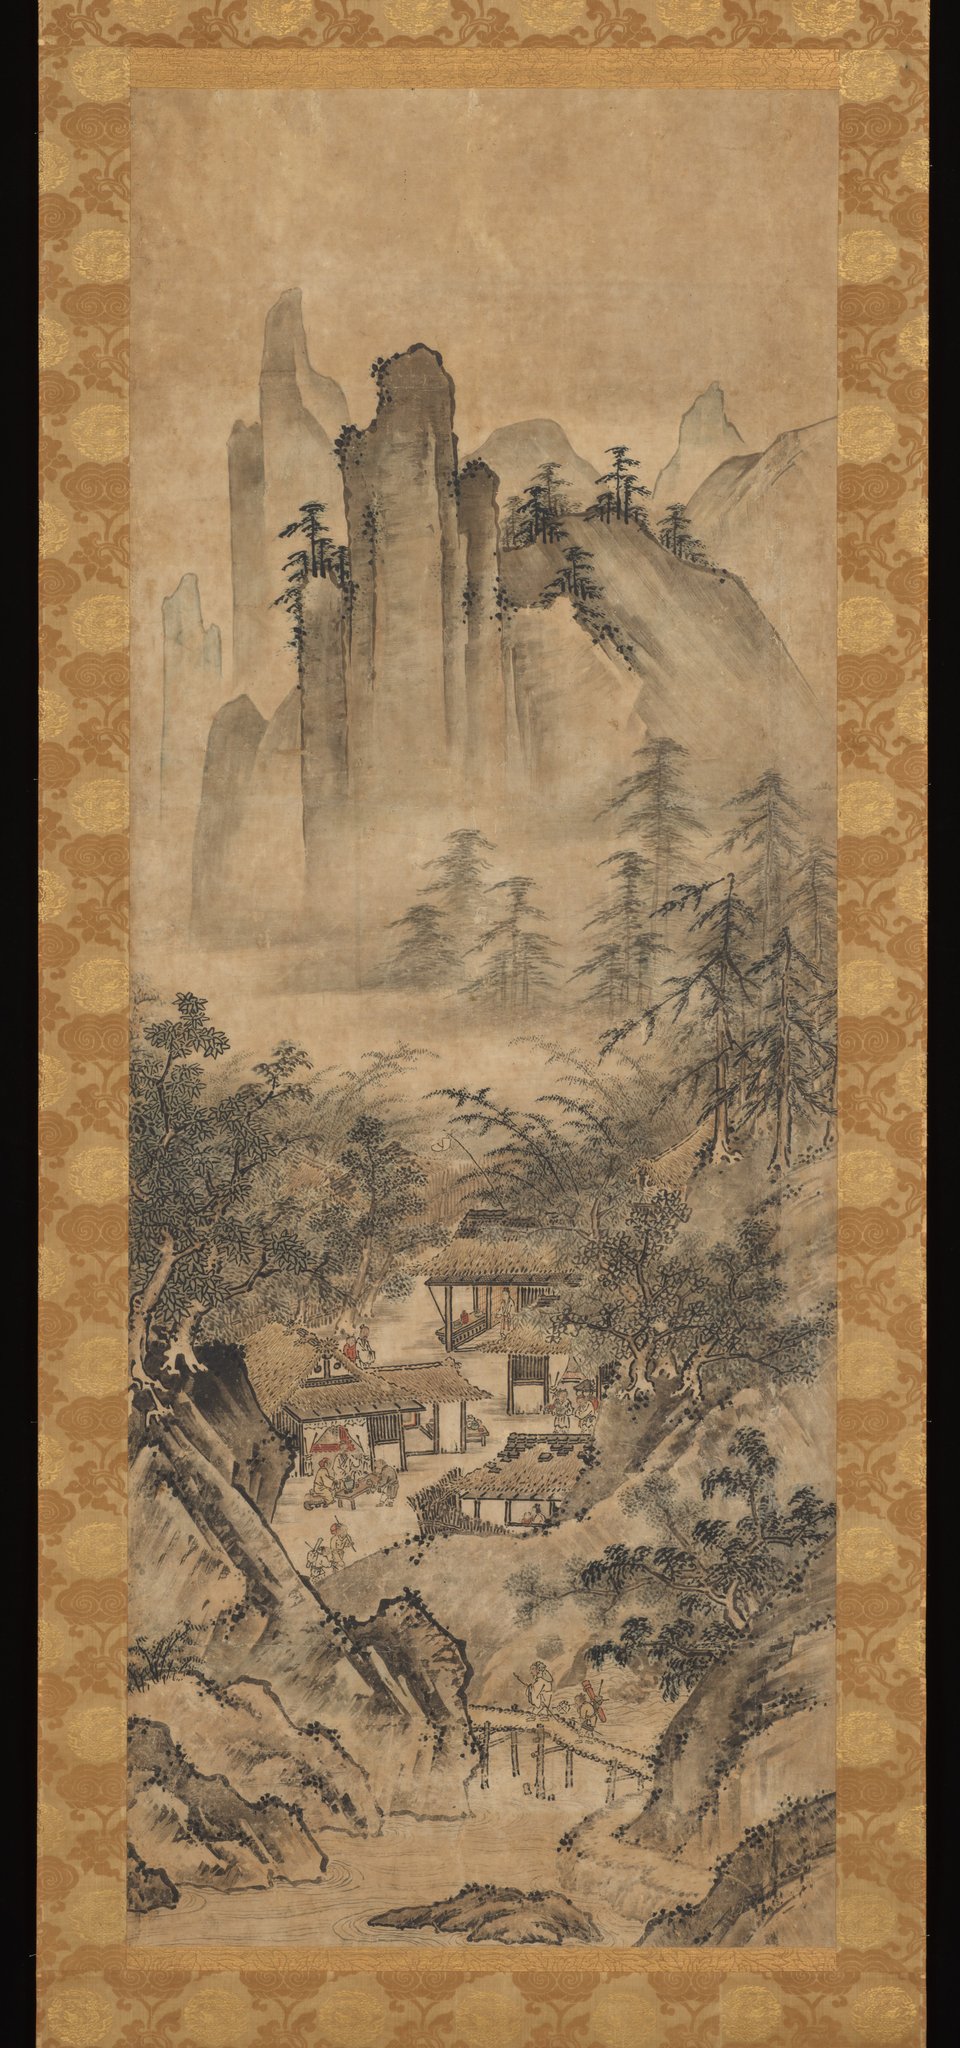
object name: hanging scroll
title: Eight Views of the Xiao and Xiang Rivers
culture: japanese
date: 1501-1600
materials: ink, paper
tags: mountains,landscapes,boats